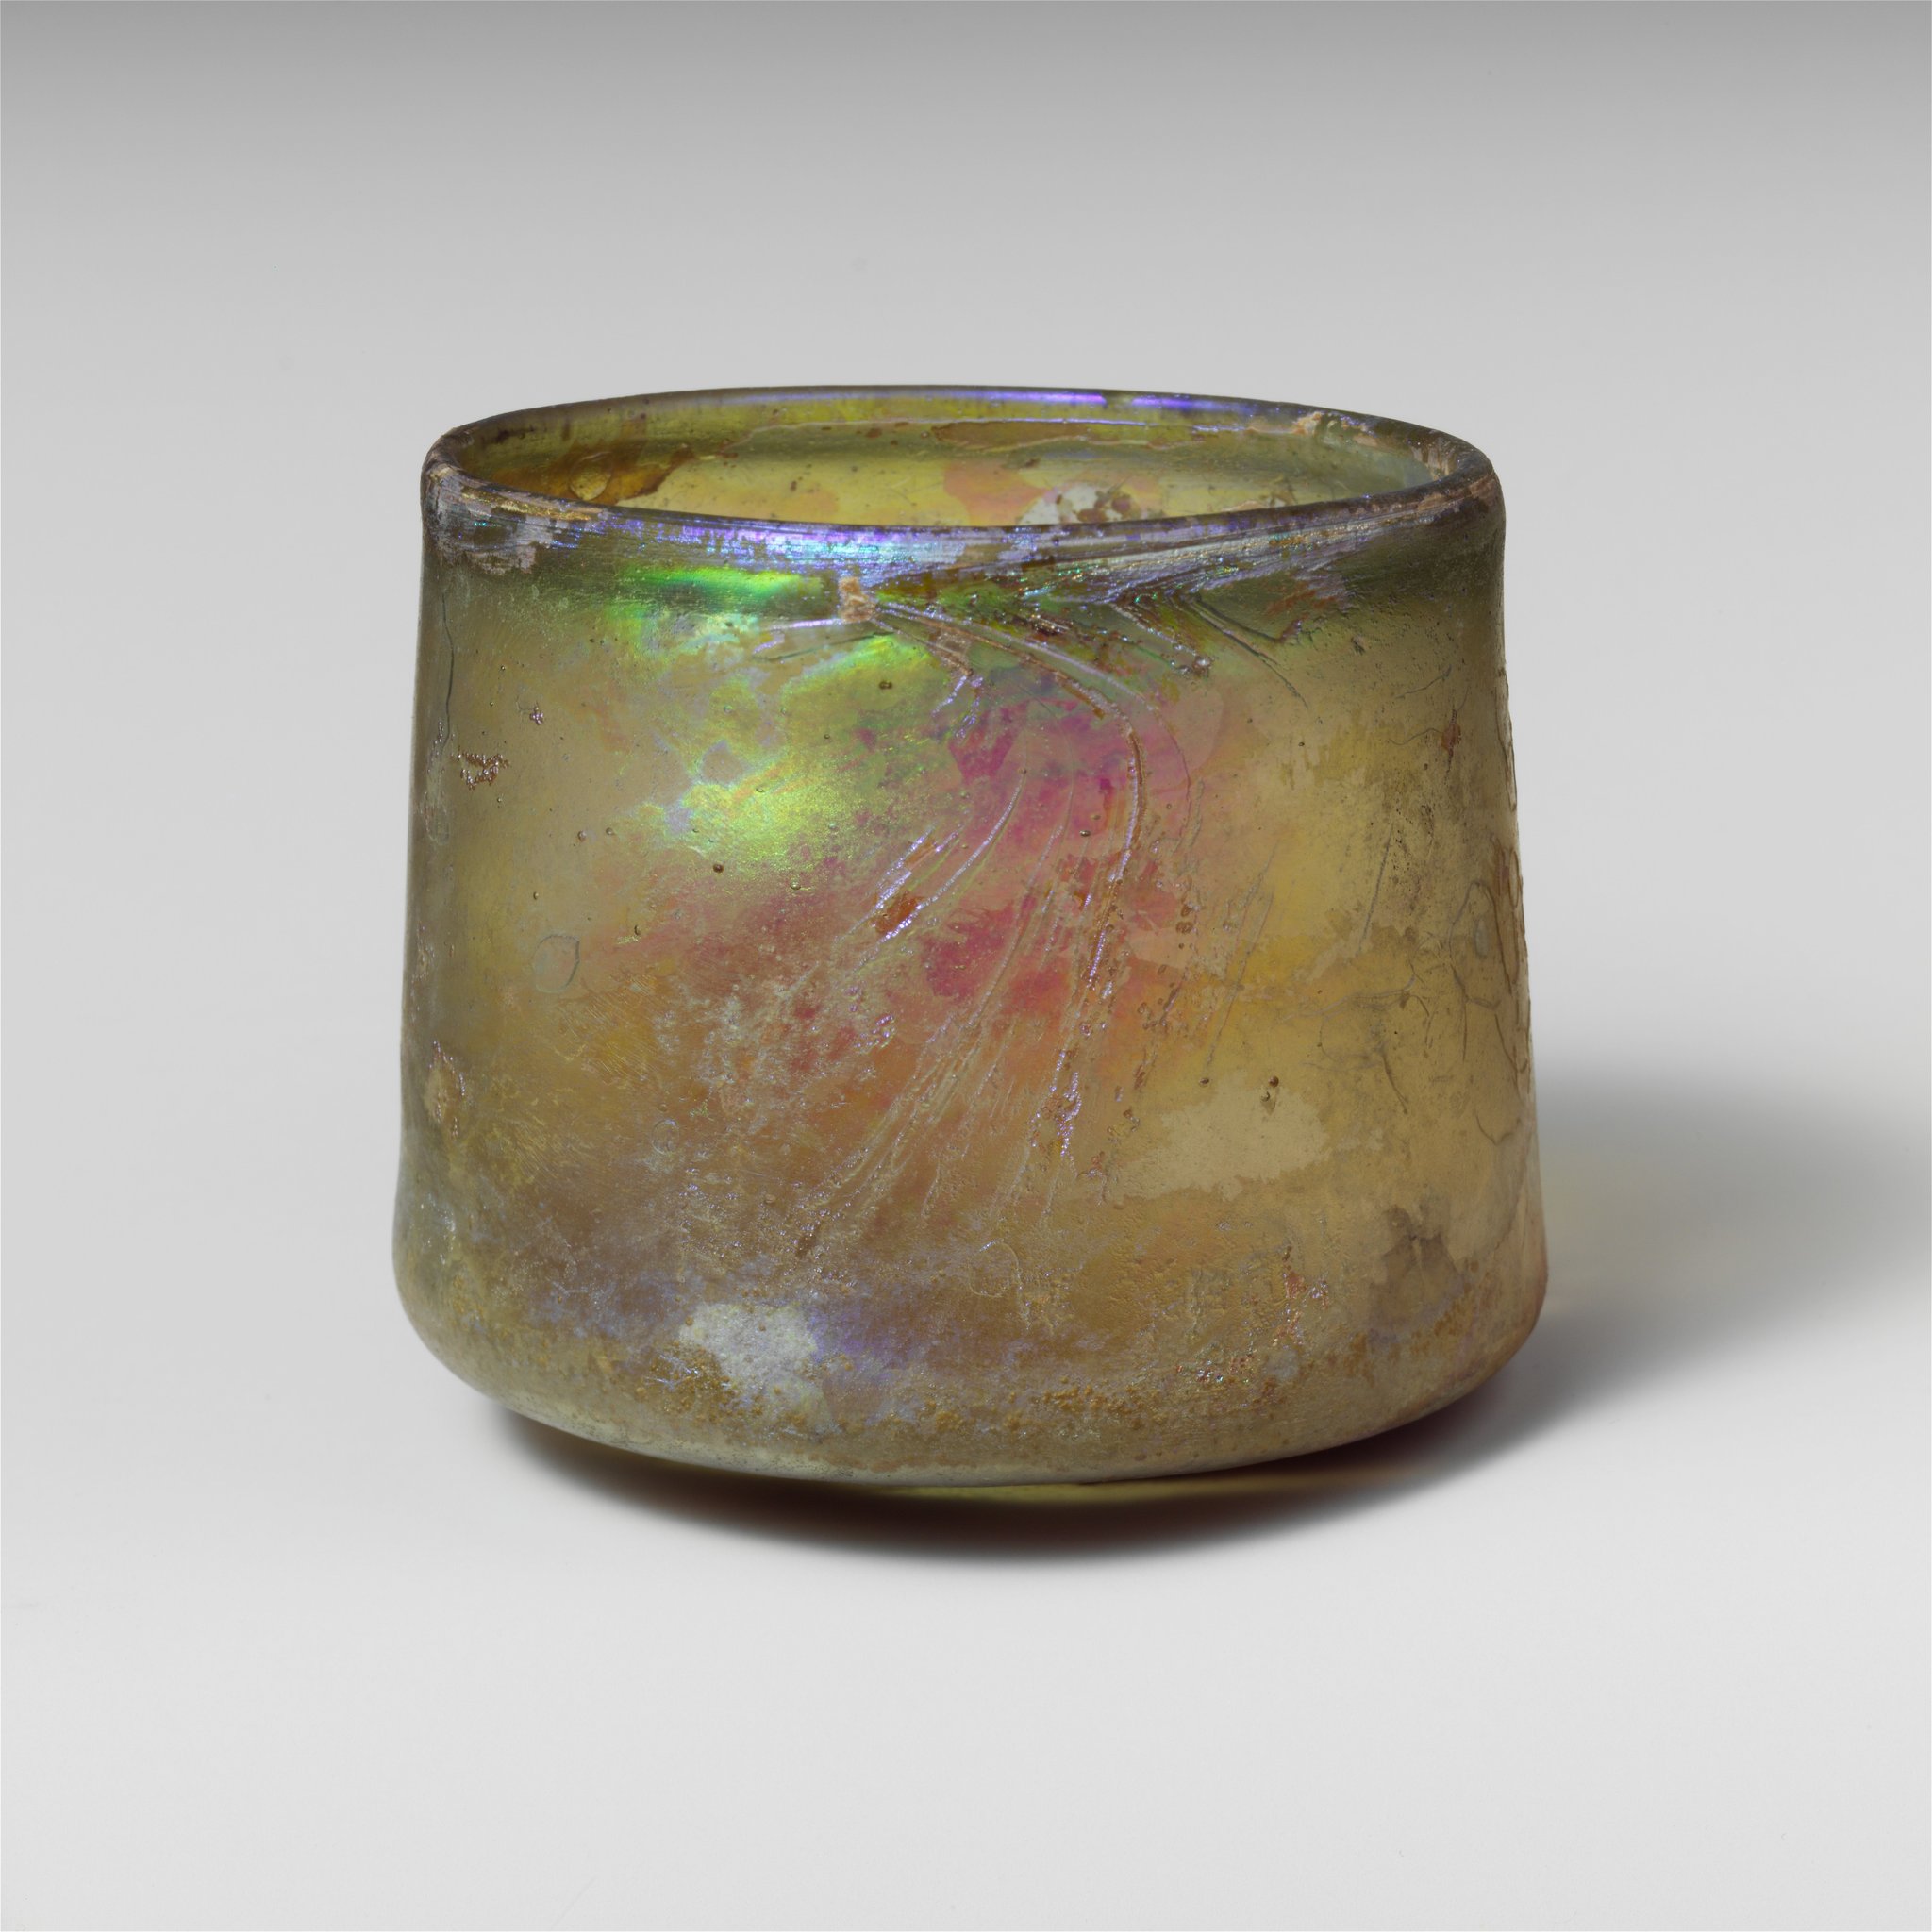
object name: beaker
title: Glass beaker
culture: roman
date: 101-300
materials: glass